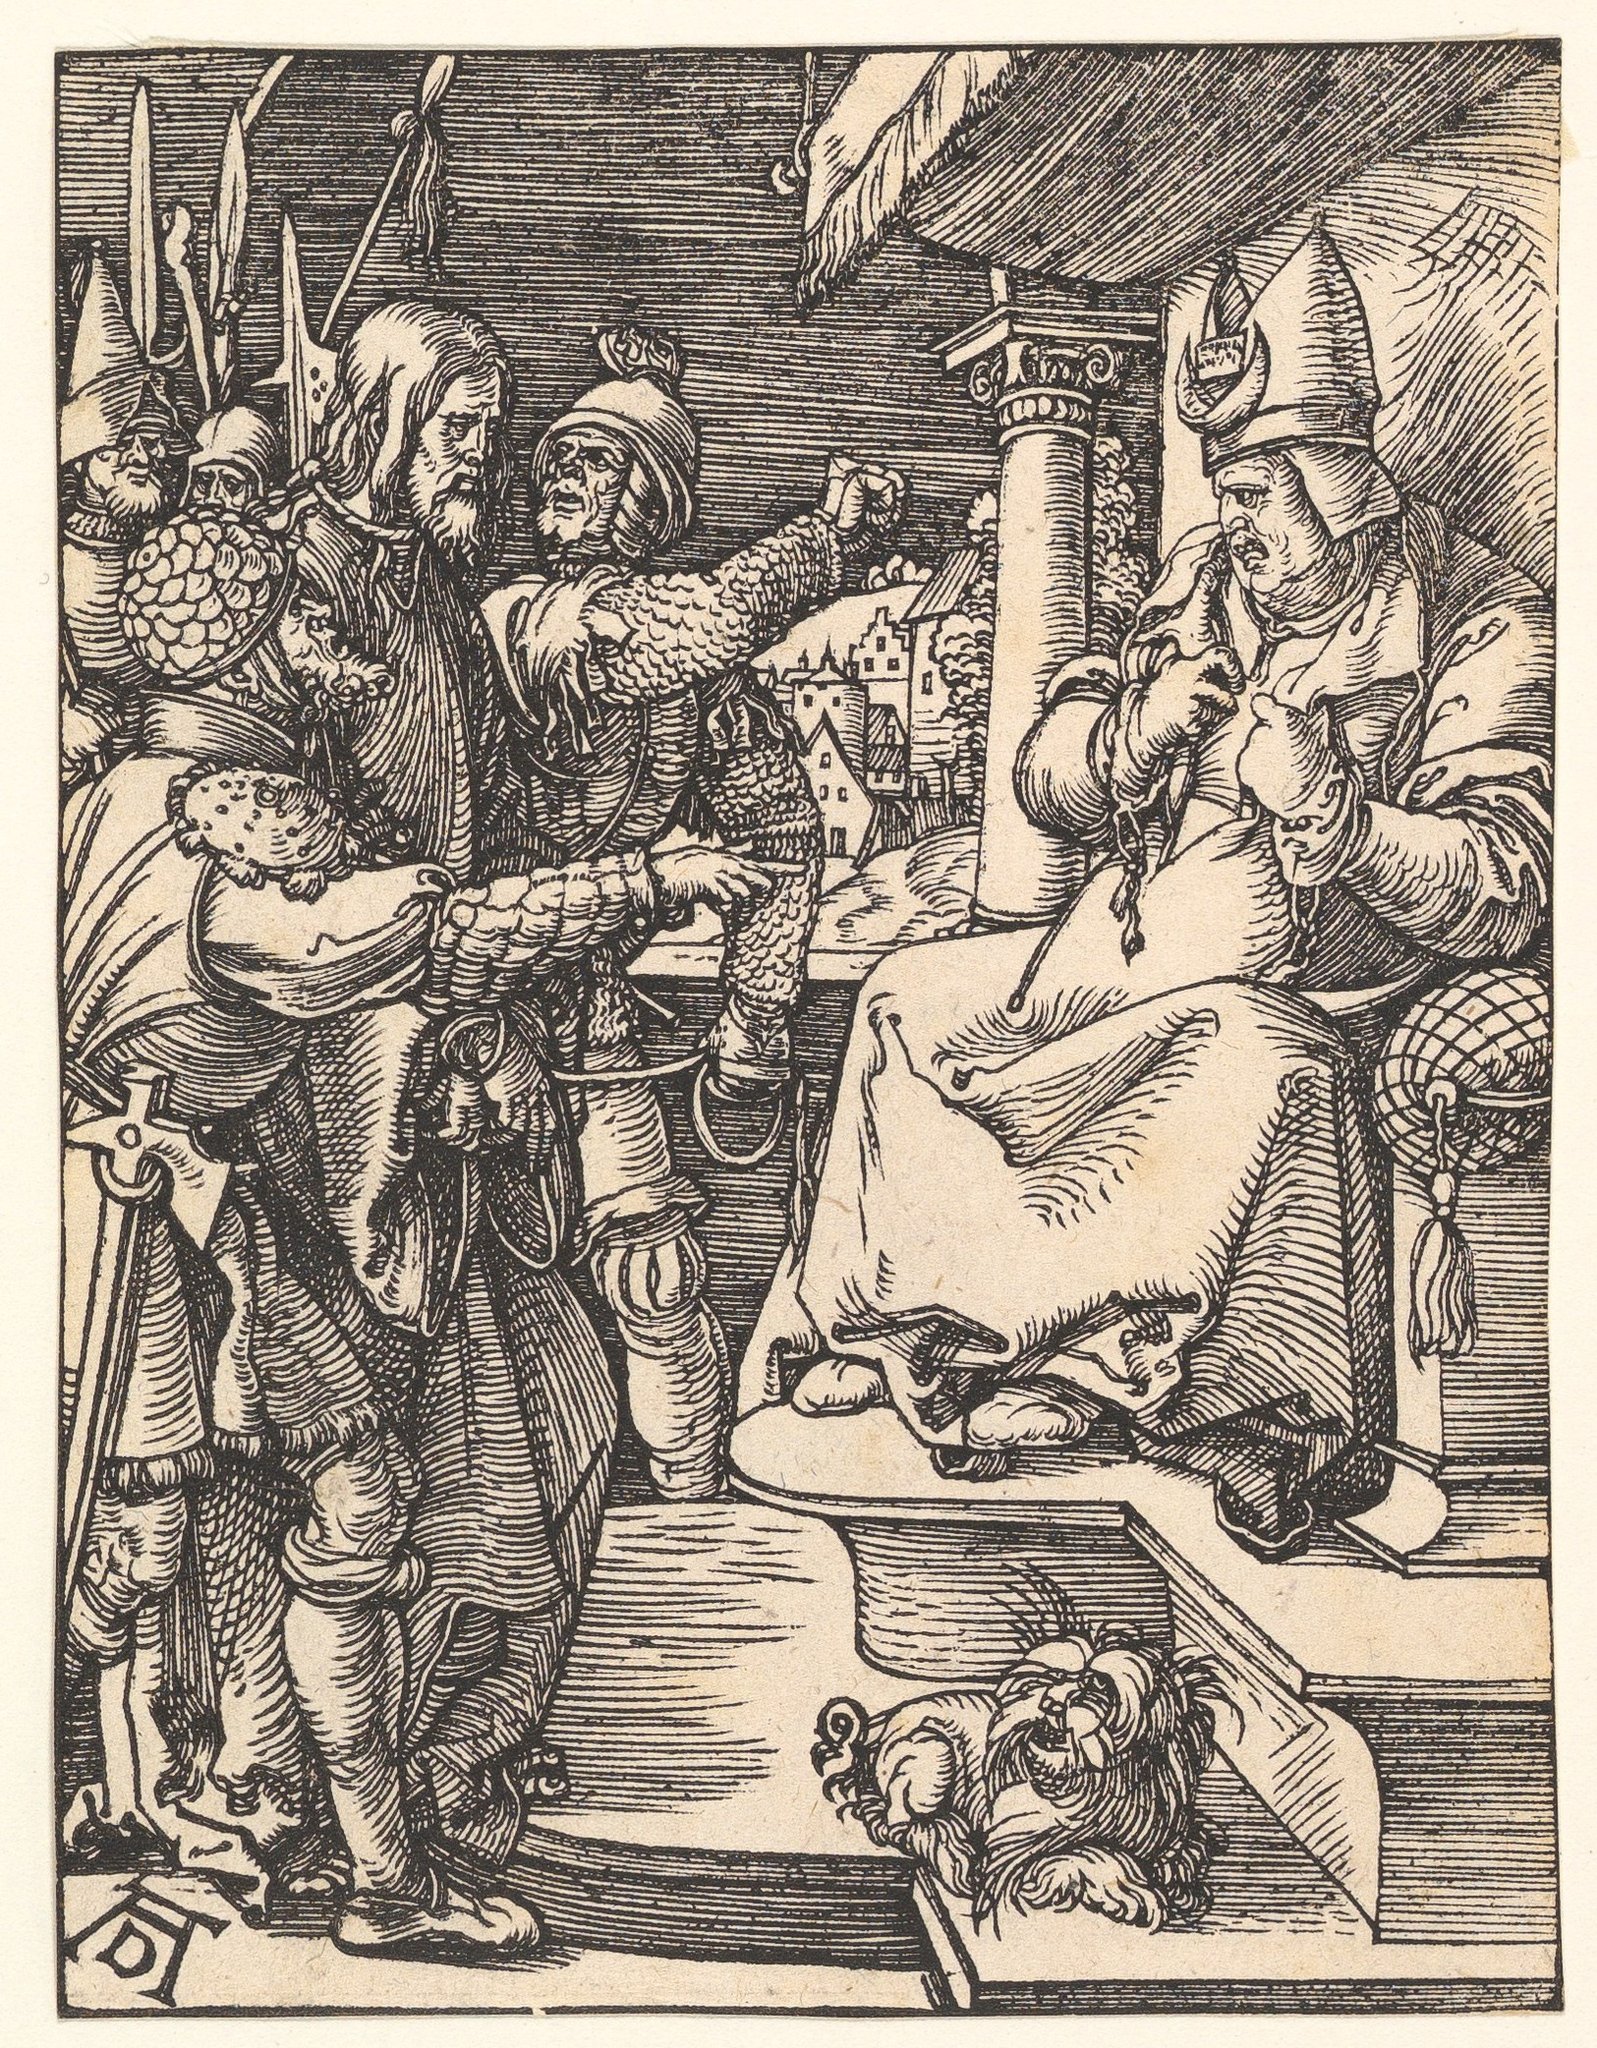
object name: print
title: Christ Before Caiaphas, from "The Small Passion"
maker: albrecht dürer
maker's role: artist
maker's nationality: german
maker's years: 1471-1528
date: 1508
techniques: woodcut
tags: animals,soldiers,men,christ